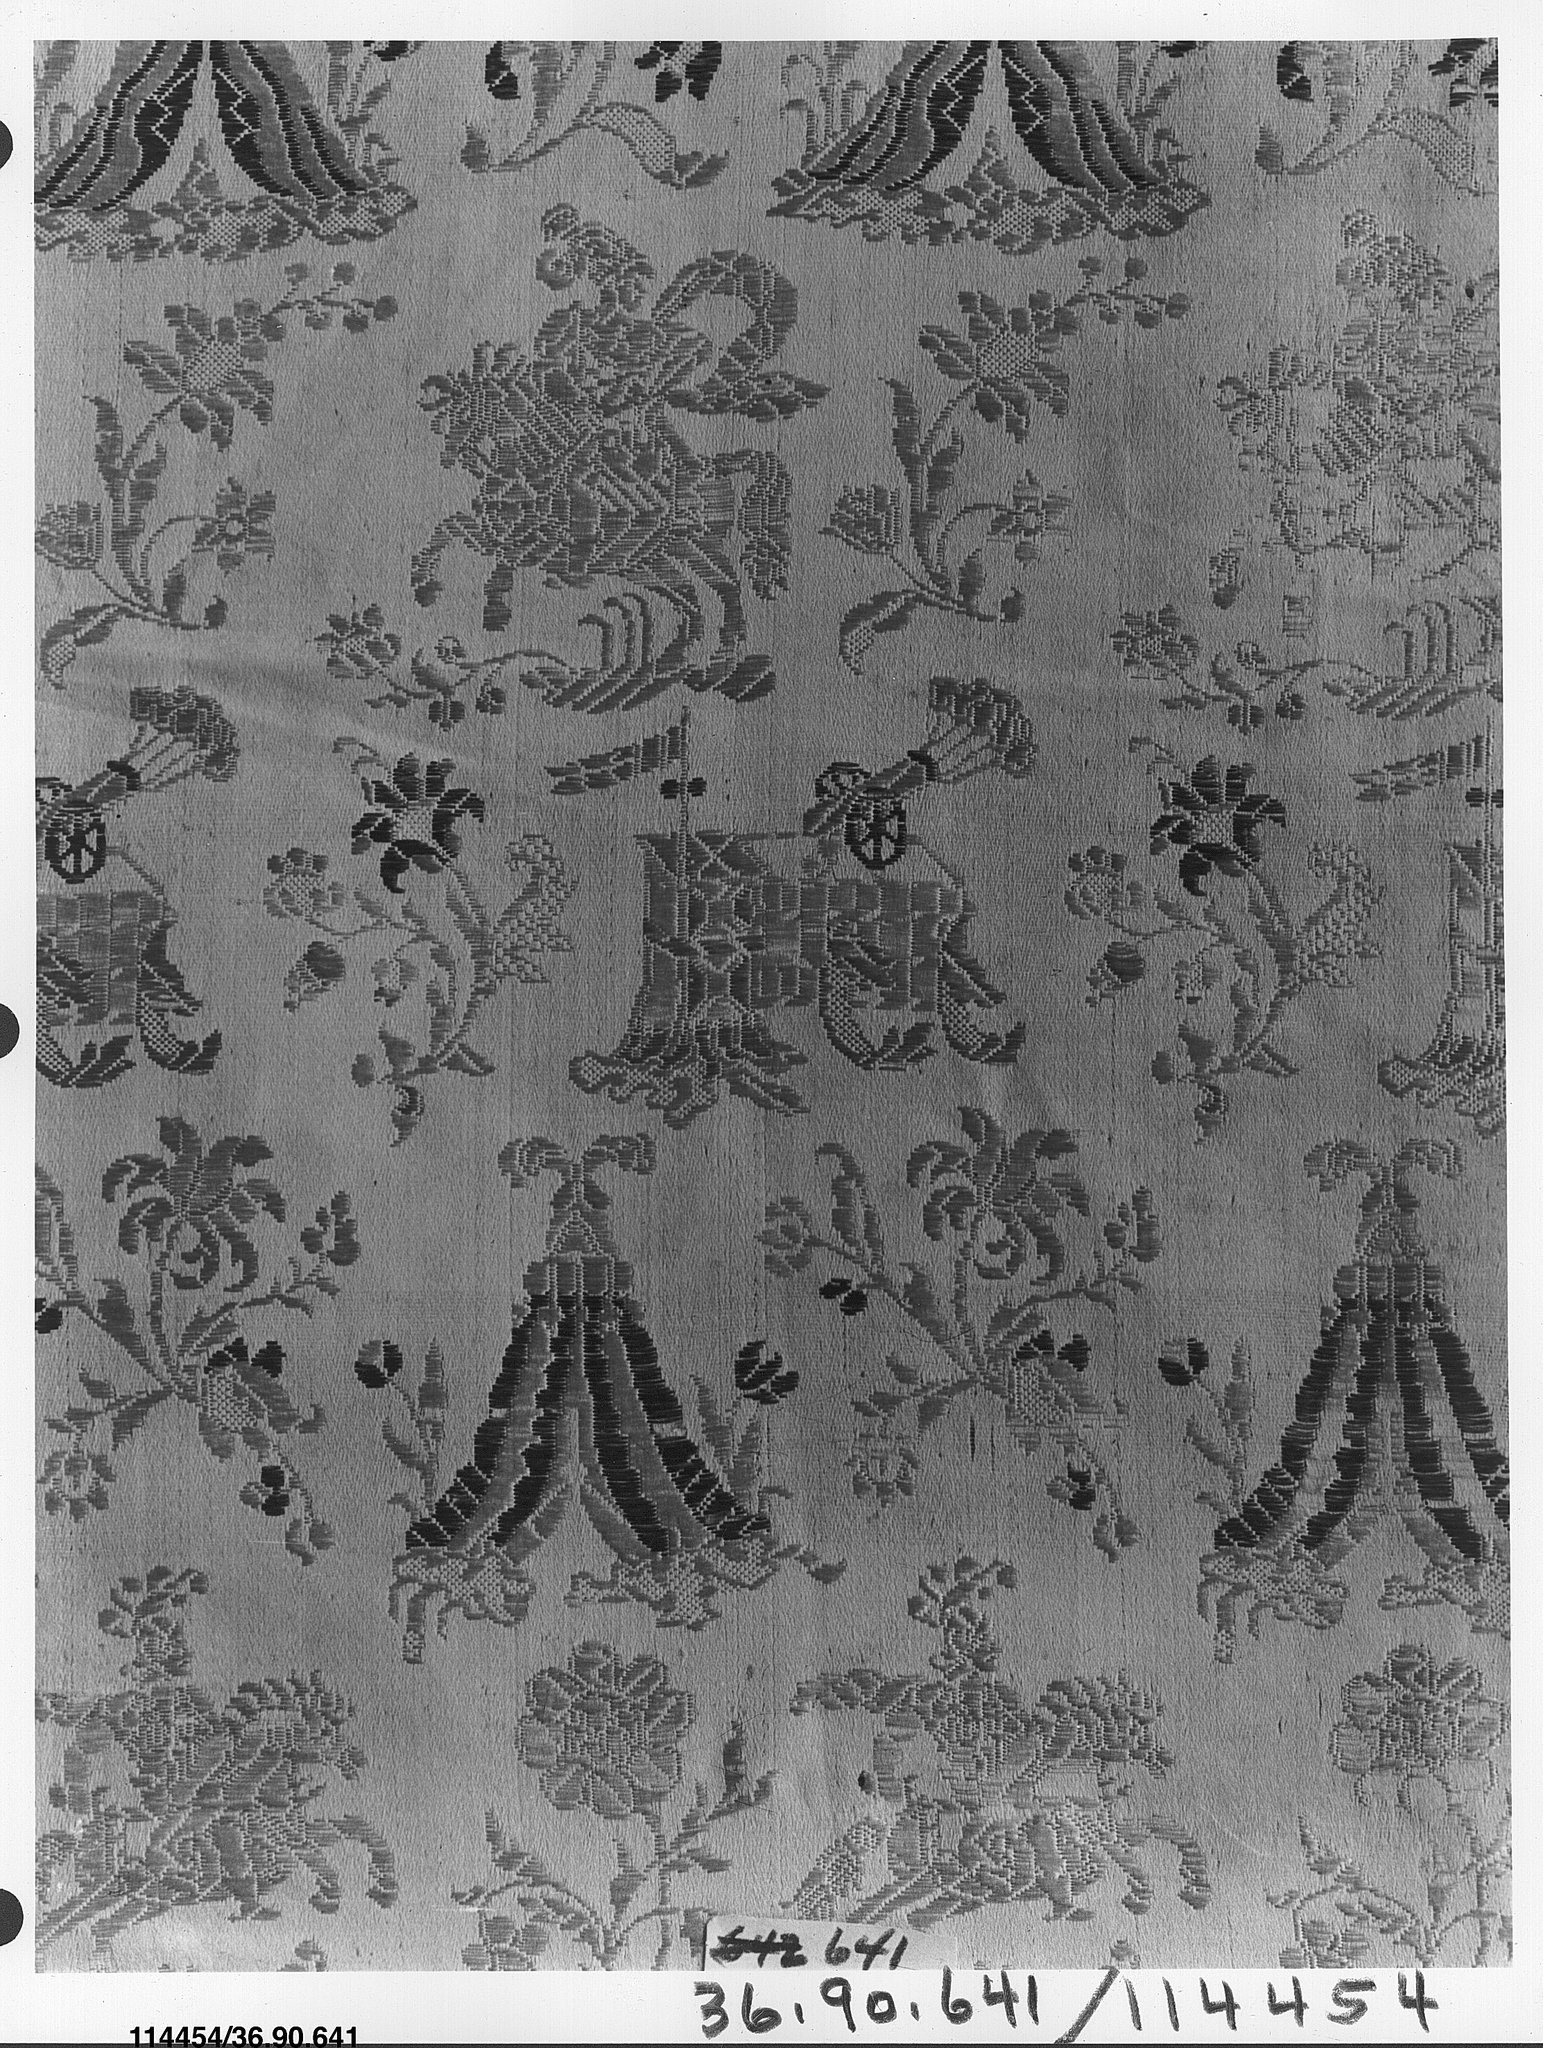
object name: piece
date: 1680-1700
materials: silk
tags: cannons,horses,flowers